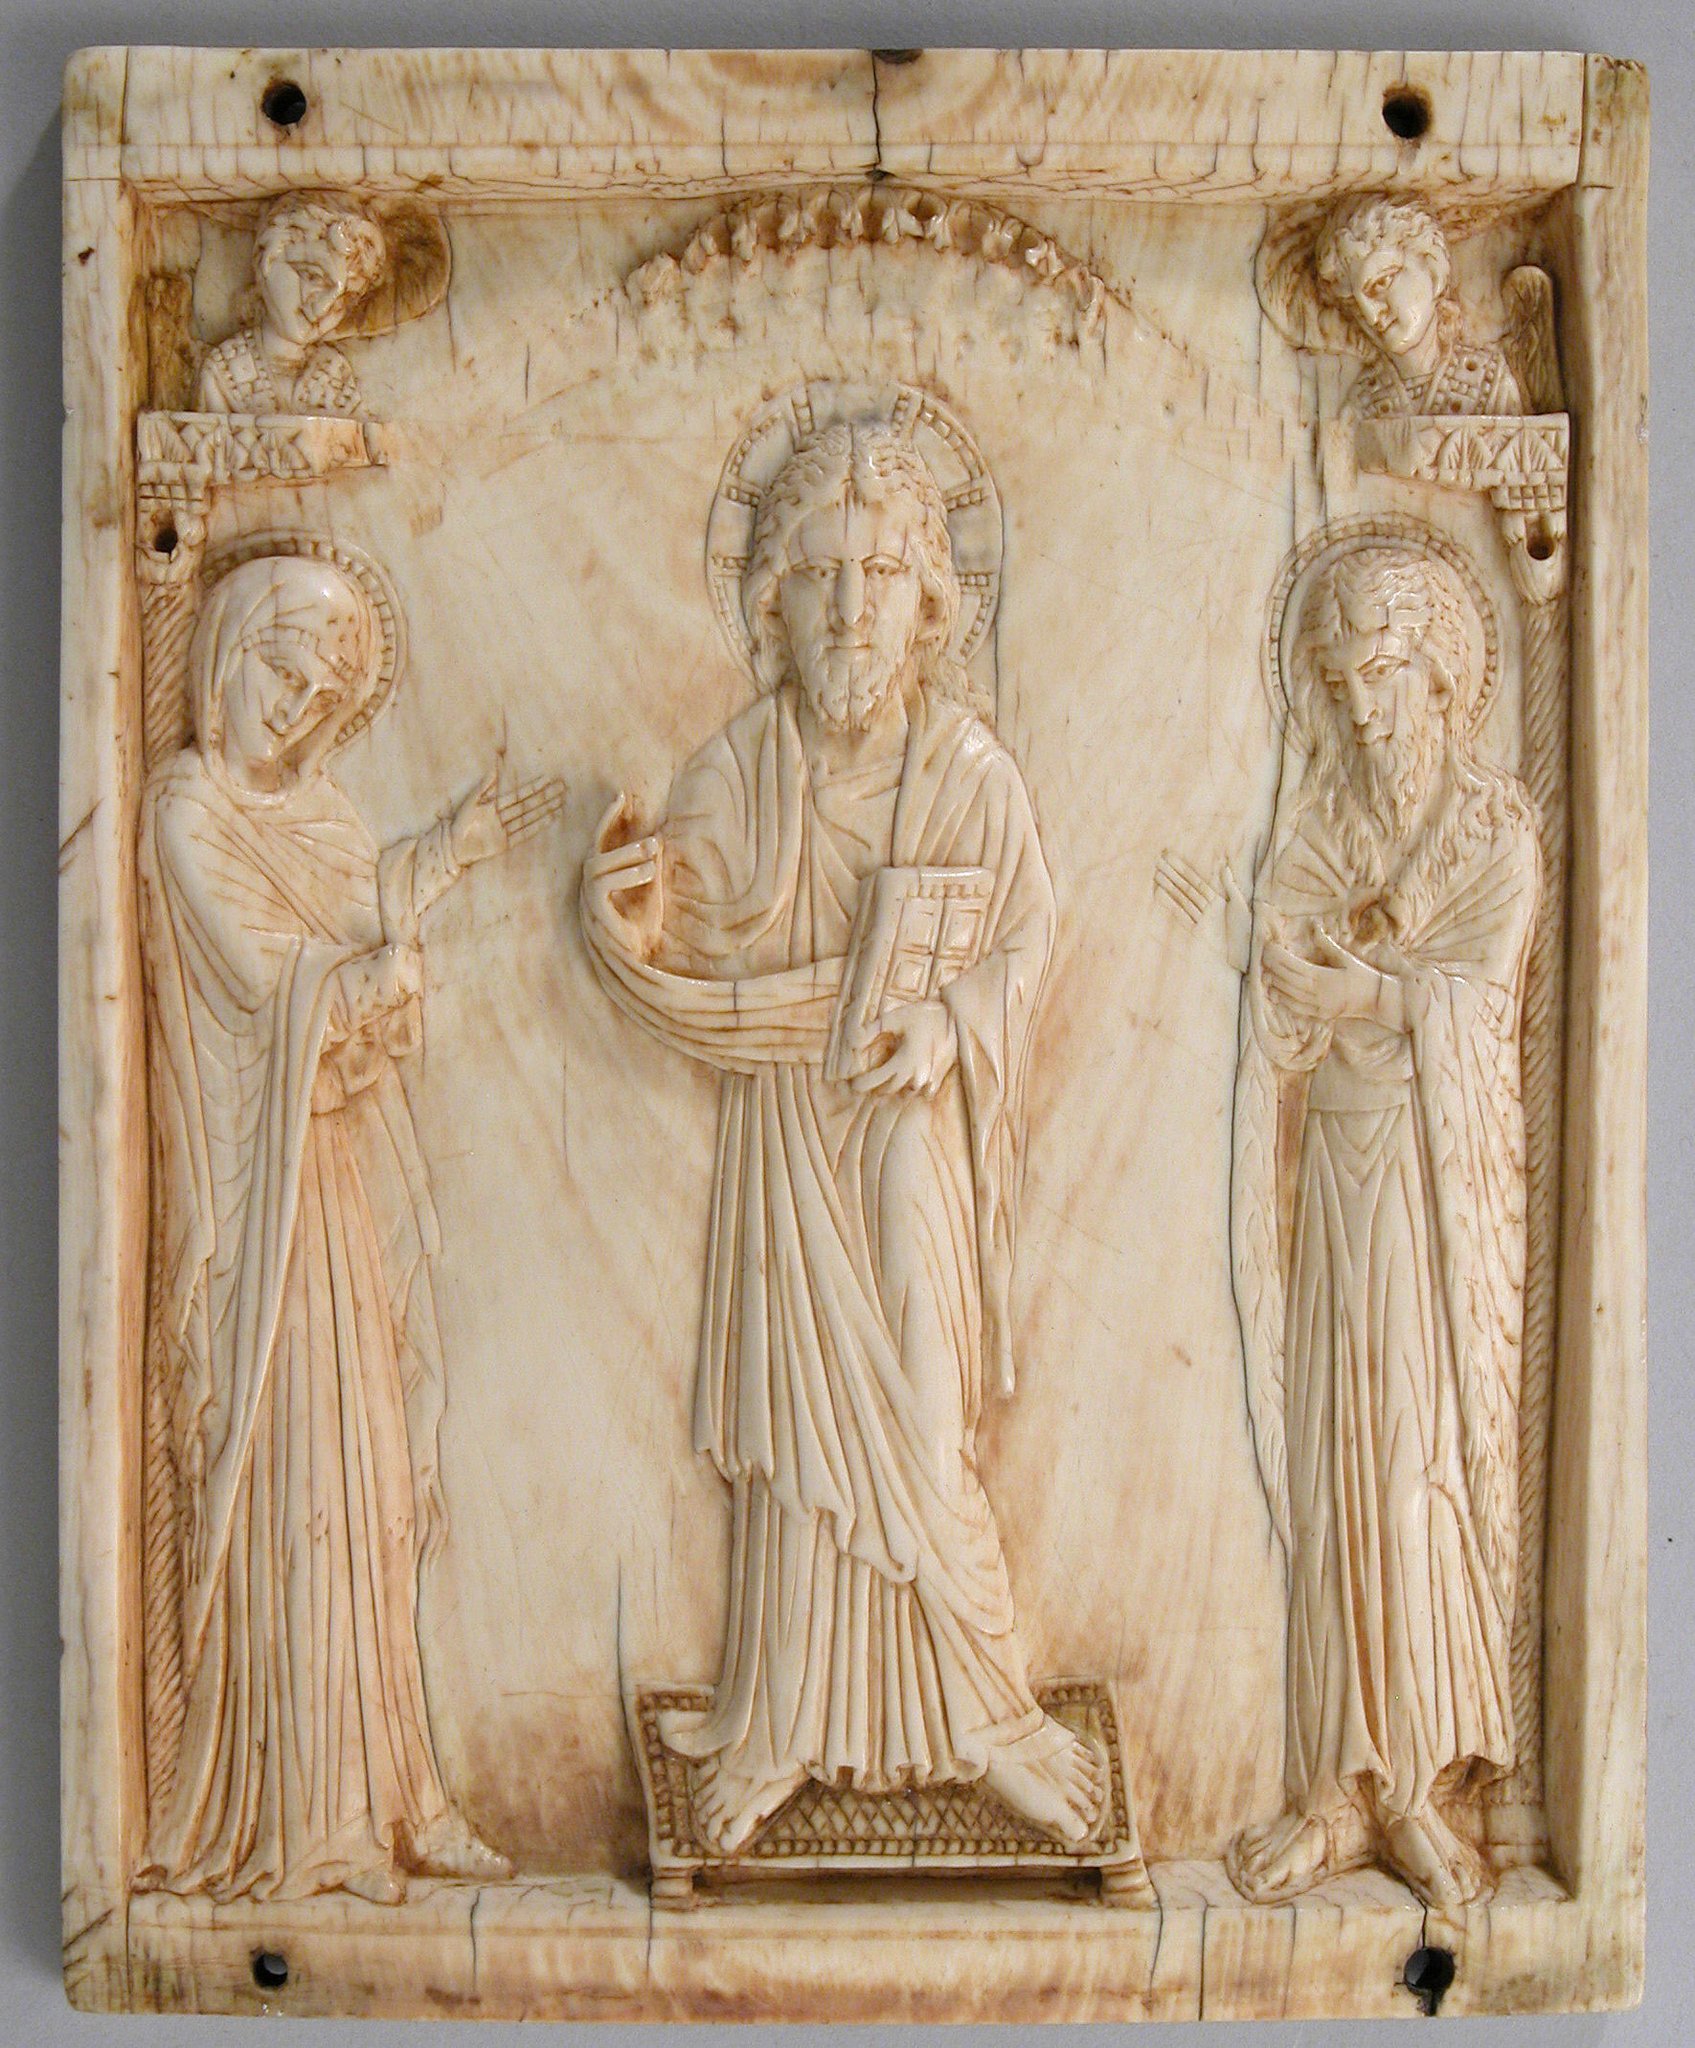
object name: plaque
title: Icon with the Deesis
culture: byzantine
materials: ivory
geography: probably constantinople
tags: christ,saint john the baptist,virgin mary